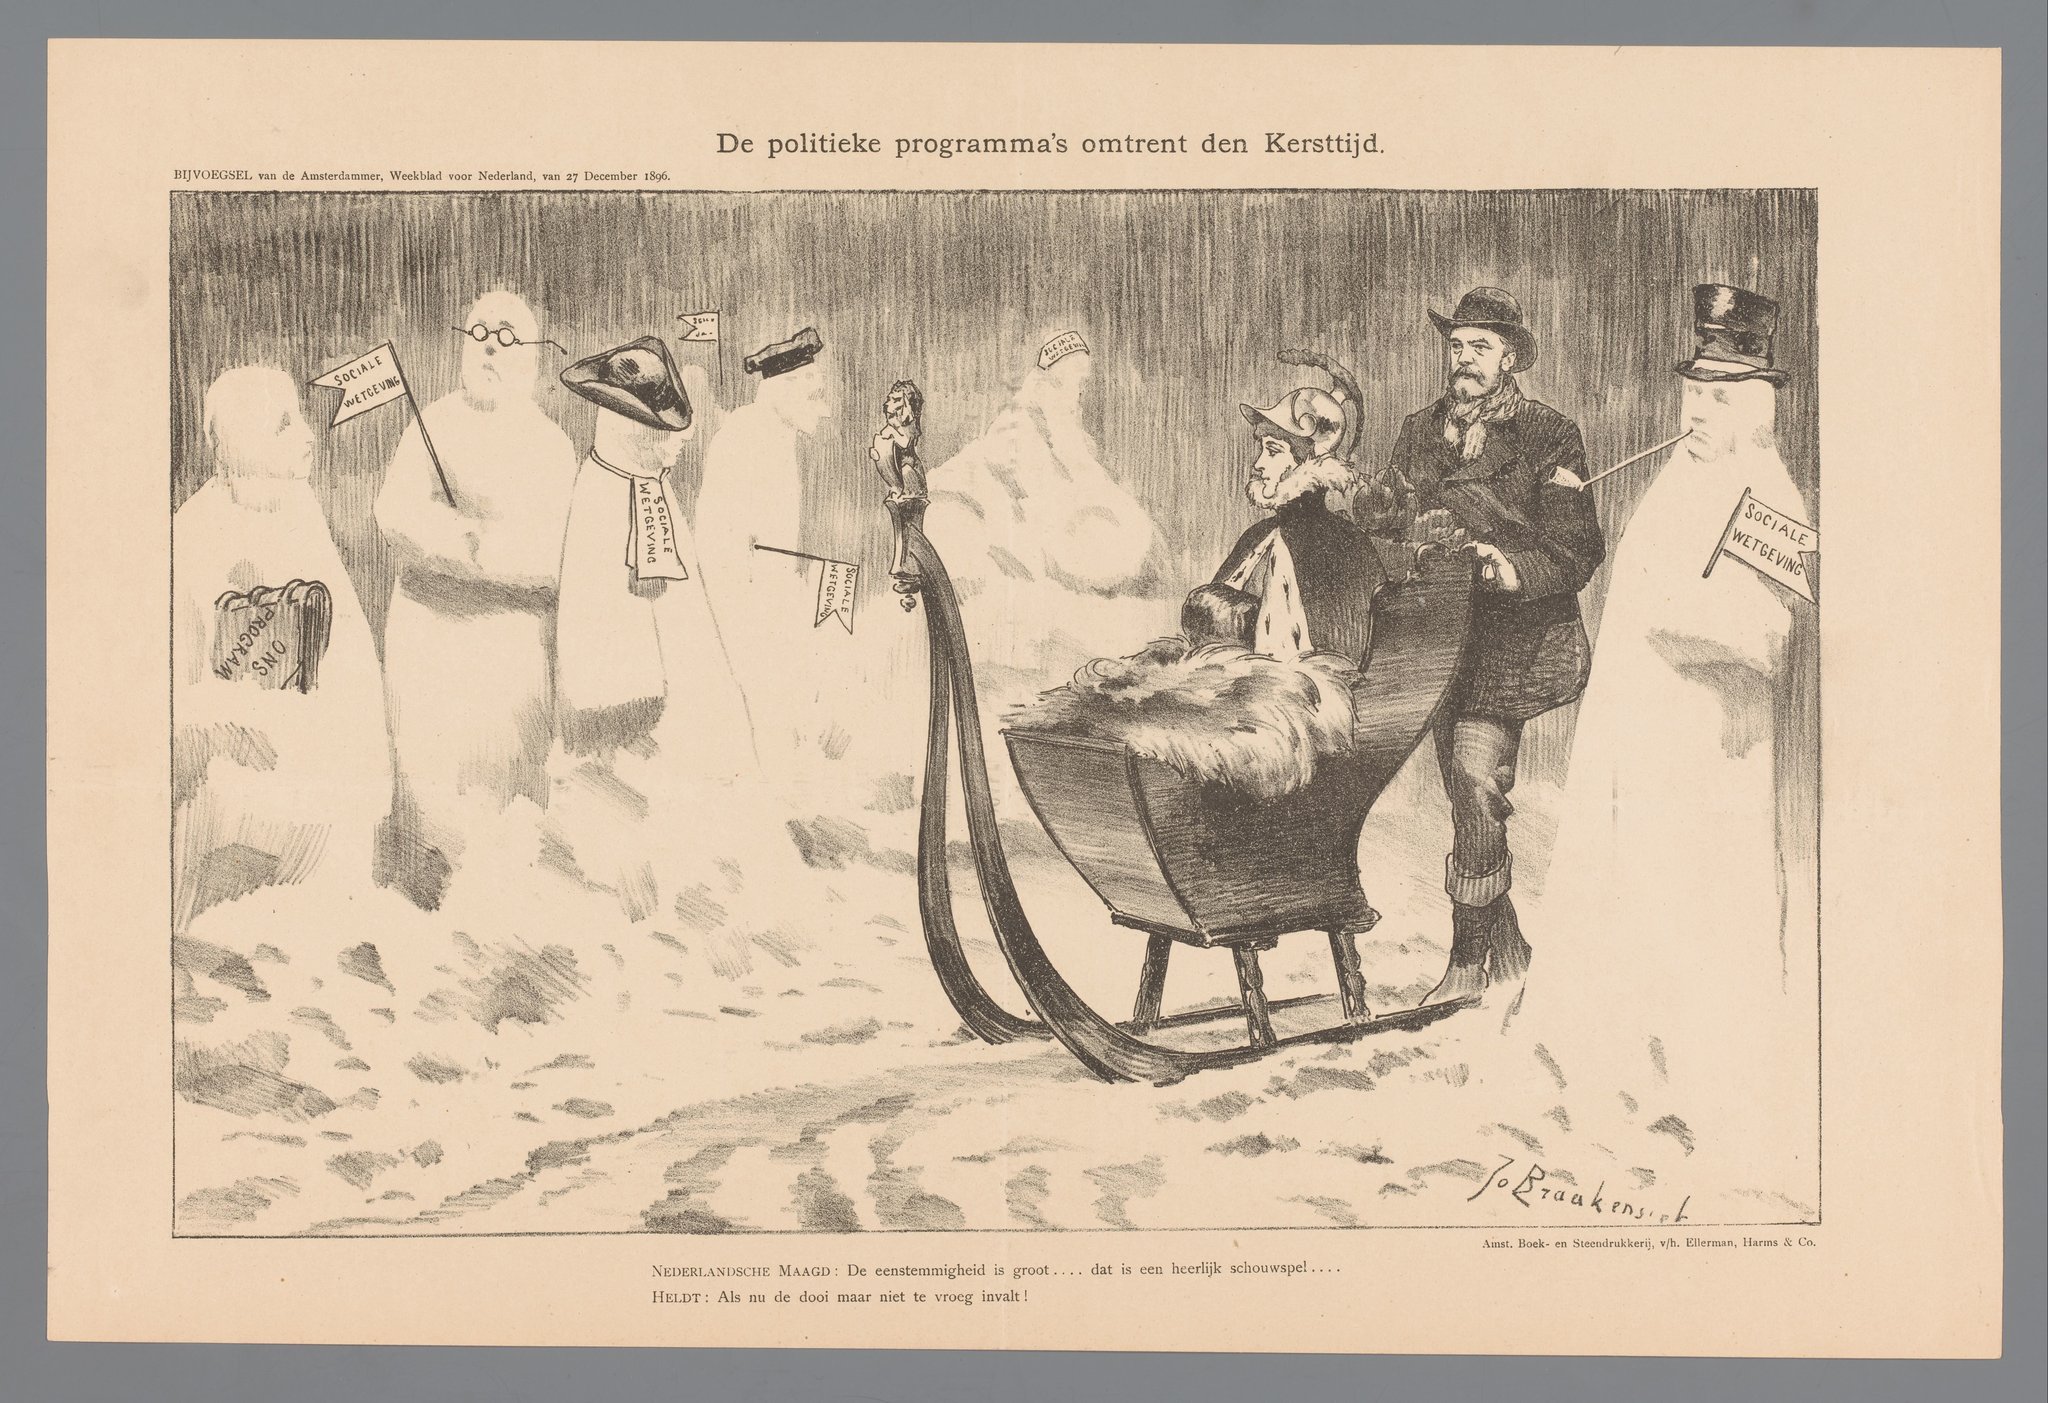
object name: cartoon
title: De politieke programma's omtrent den Kersttijd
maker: johan braakensiek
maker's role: draughtsman, print maker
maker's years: 1858-1940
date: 1896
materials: paper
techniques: lithograph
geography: amsterdam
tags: amsterdam, furniture worker, personifications of countries, nations, states, districts, etc., (making a) snowman, sleigh, sledge (non-sport), politics, political caricatures and satires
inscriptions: date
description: Prent uit het bijvoegsel van: De Amsterdammer. Weekblad voor Nederland, 27 december 1896.